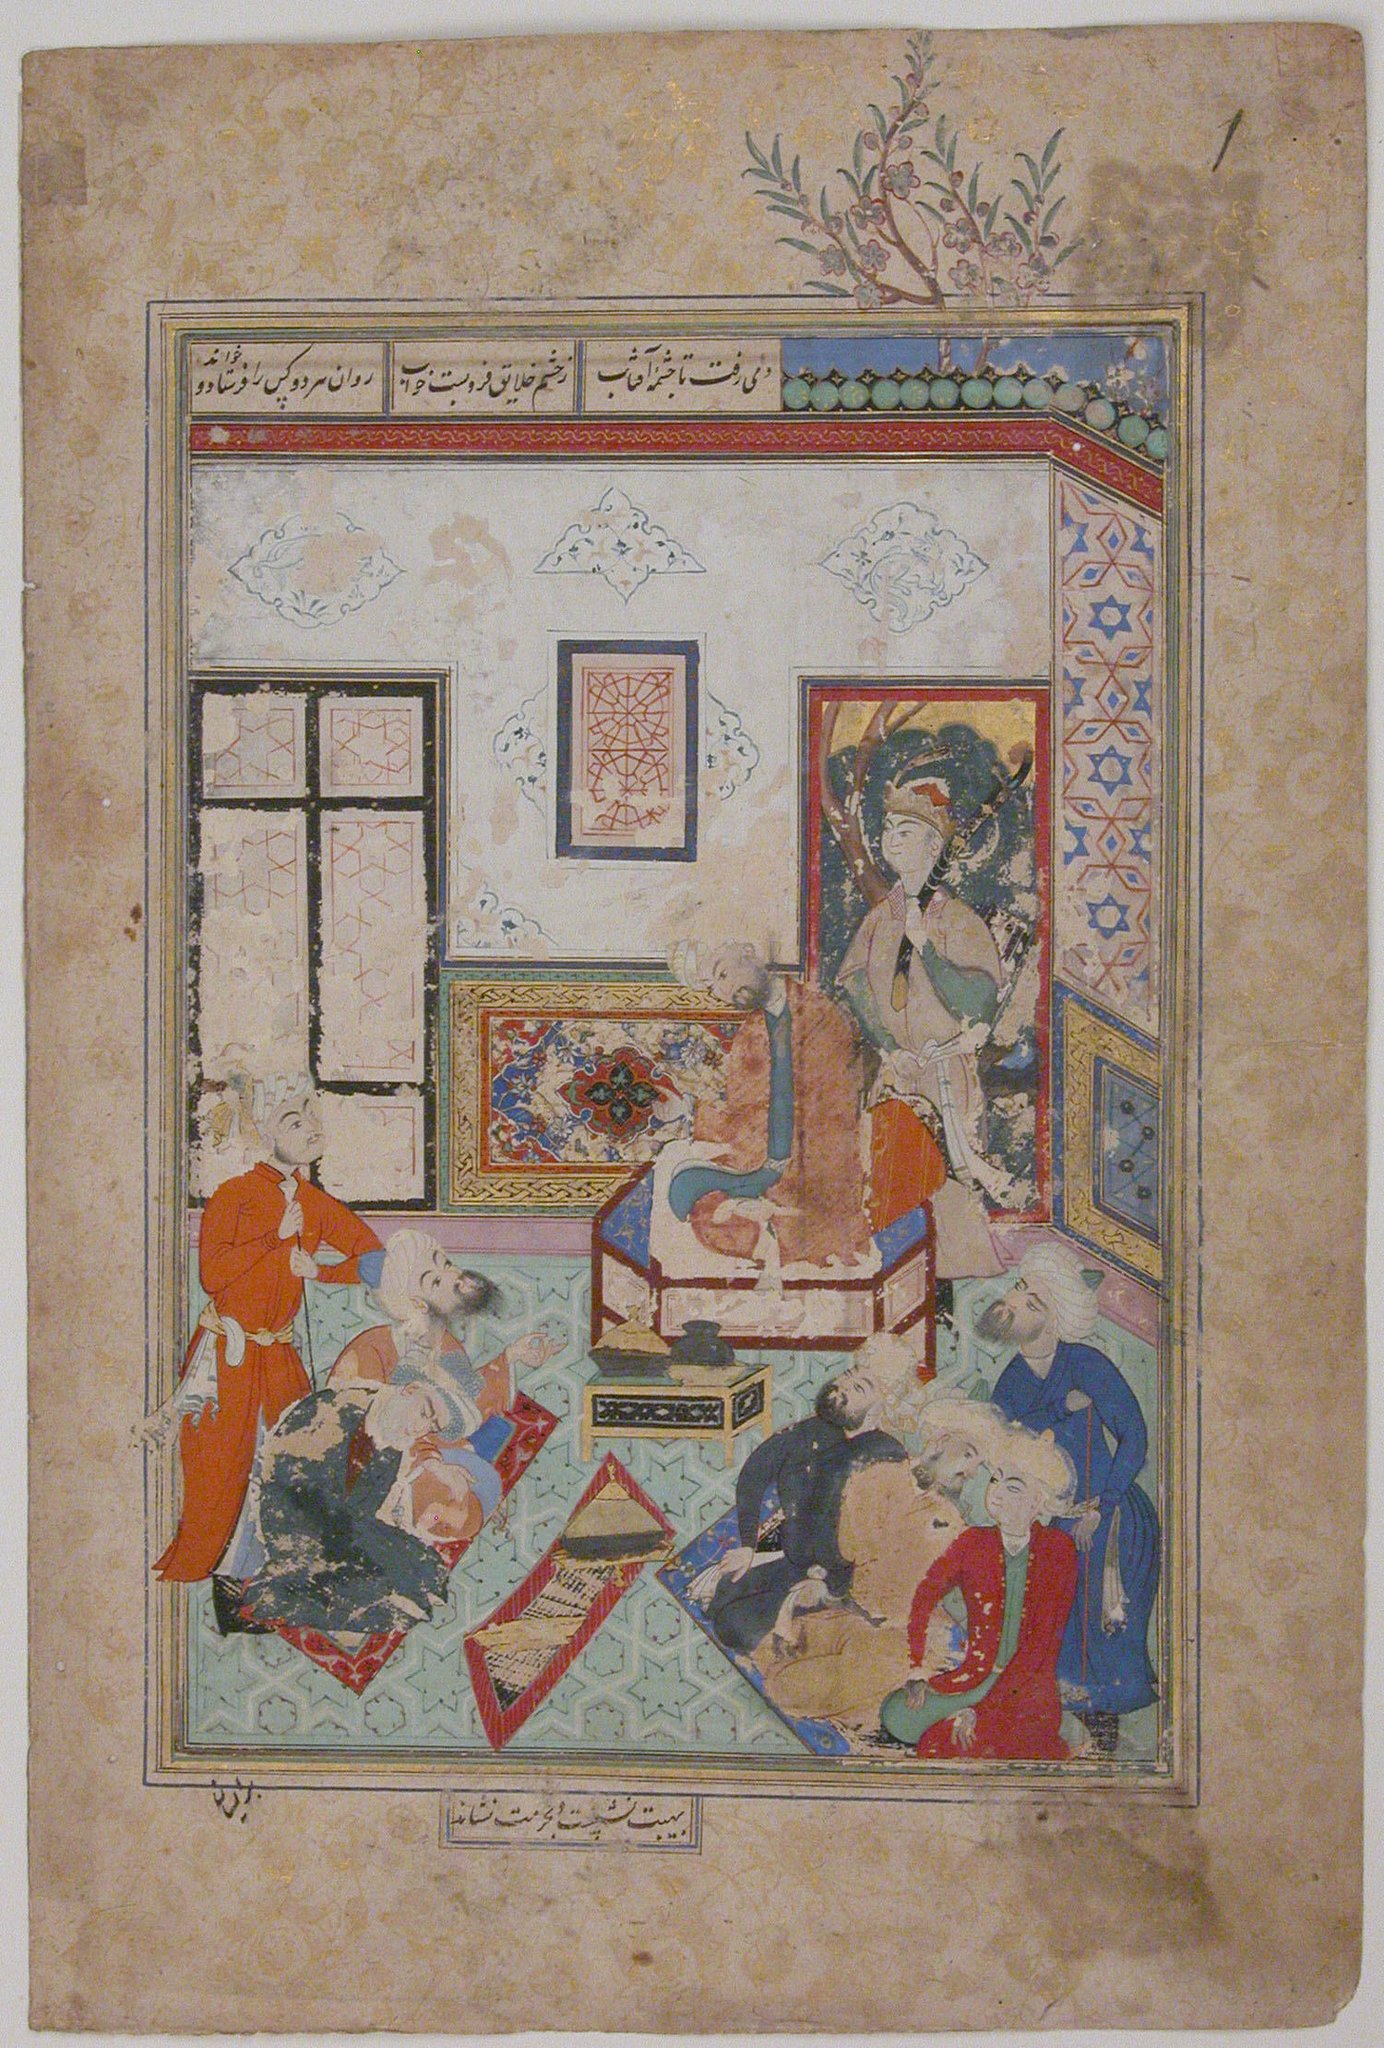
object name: folio from an illustrated manuscript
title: "King Salih of Syria Entertaining Two Dervishes", Folio from a Bustan (Orchard) of Sa'di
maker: sa'di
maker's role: author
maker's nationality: iranian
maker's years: 1213-1291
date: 1601-1700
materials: gold, ink, paper, watercolor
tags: men